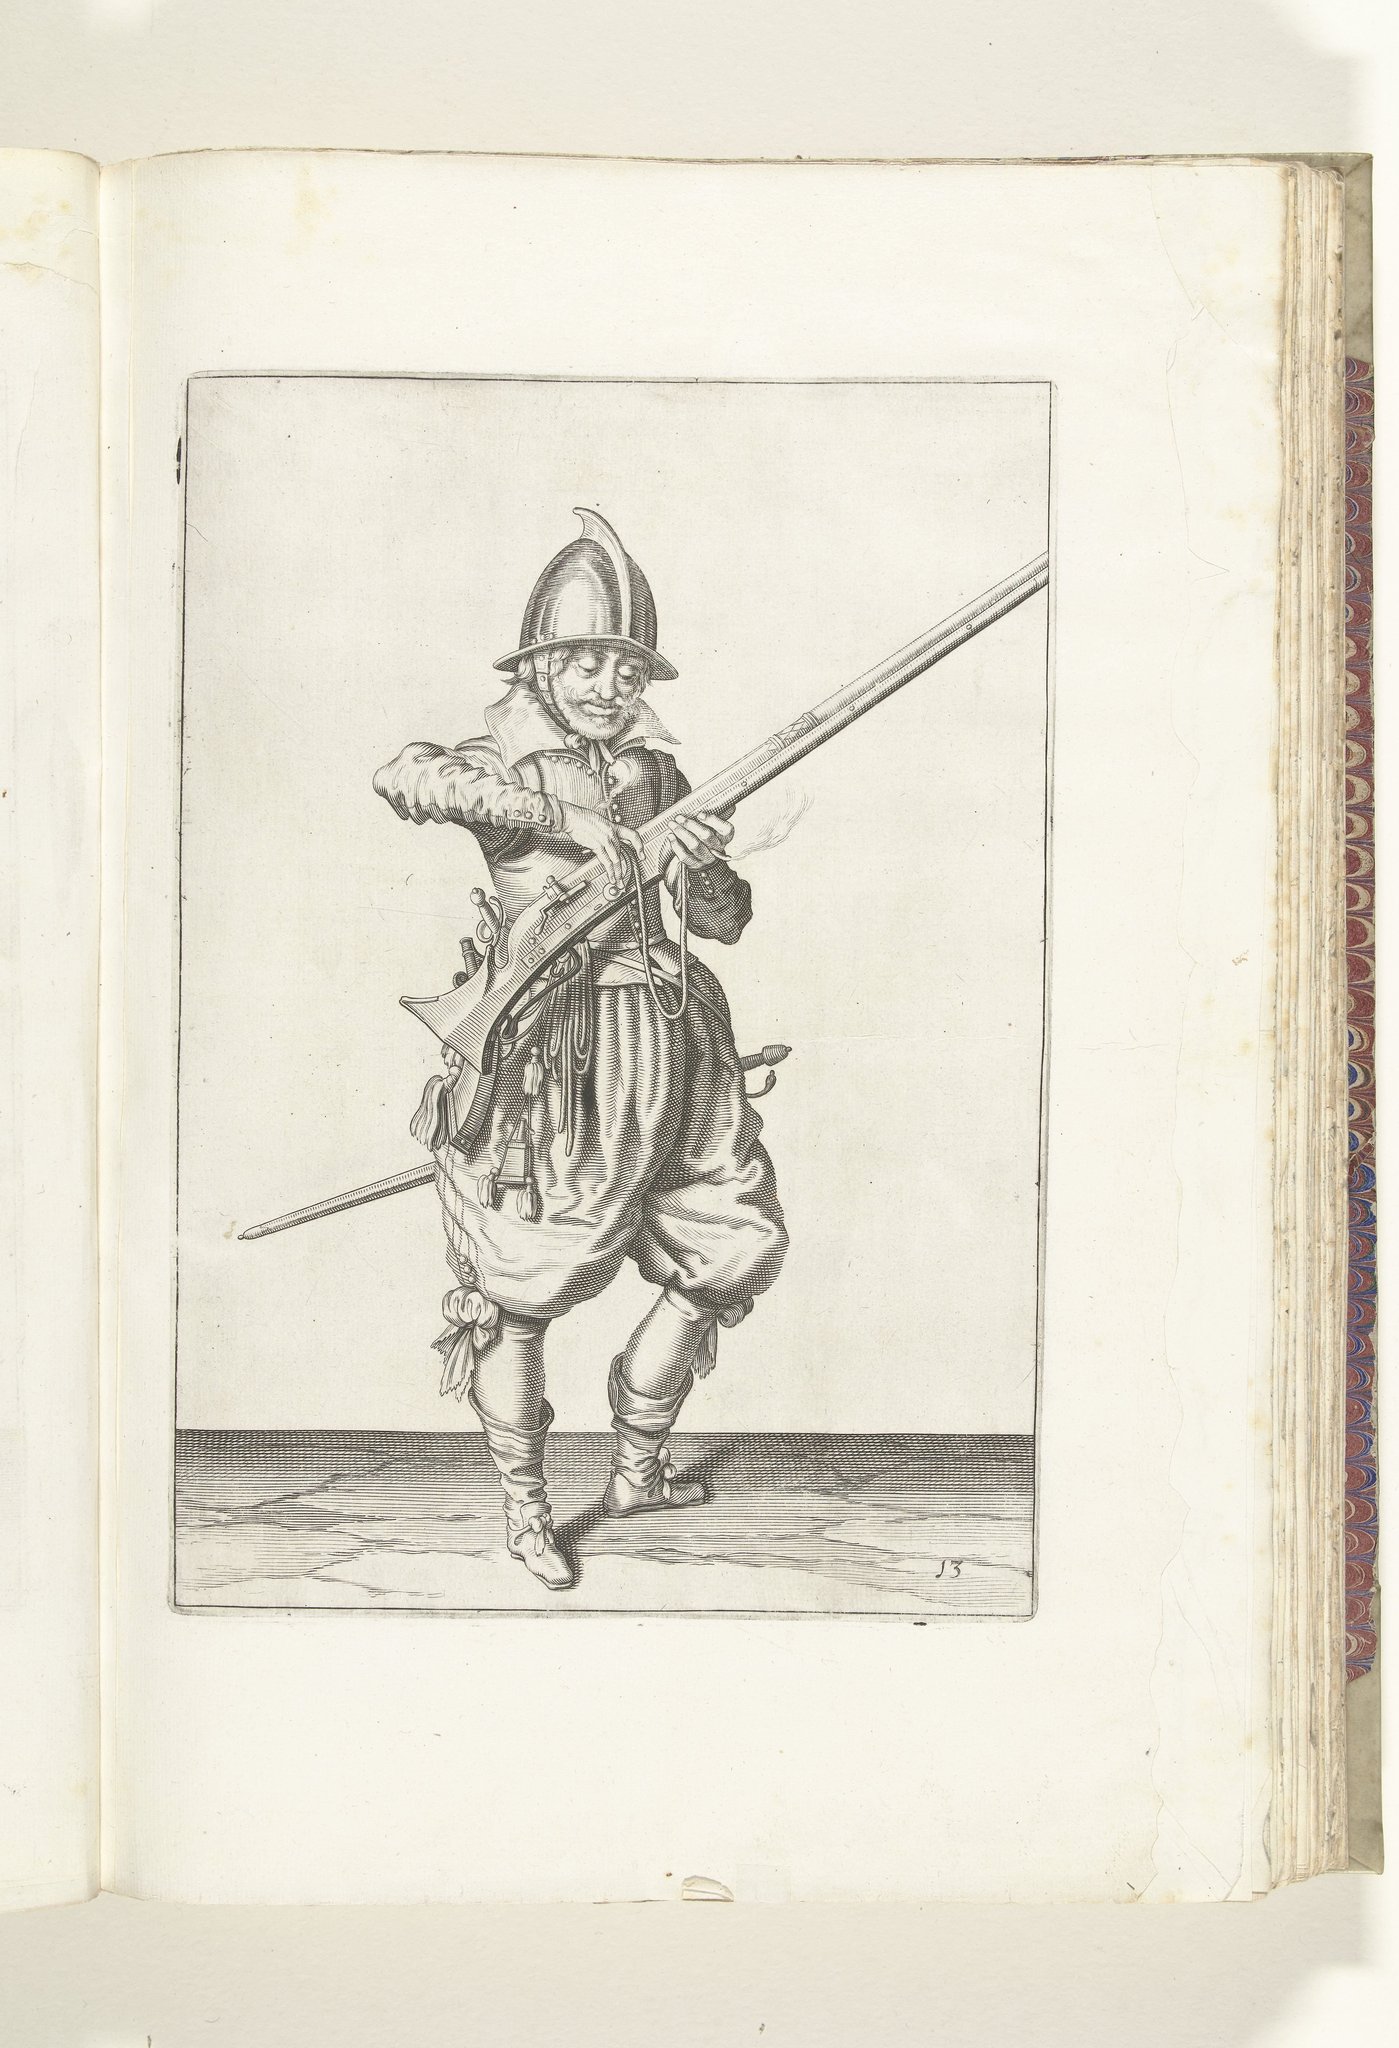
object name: print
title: Soldaat die zijn lont van de haan van zijn roer losmaakt (nr. 13), ca. 1600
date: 1597-1607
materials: paper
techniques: engraving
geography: amsterdam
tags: the hague, maurice (prince of orange), handling of weapons ~ military training, weapons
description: Een soldaat, ten voeten uit, naar rechts, die een roer (een bepaald type vuurwapen) met zijn linkerhand vasthoudt (nr. 13), ca. 1600. Met zijn rechterhand maakt hij de brandende lont los die op de haan (onderdeel van het ontstekingsmechanisme) van zijn roer ligt. Plaat 13 in de instructies voor het hanteren van de roer. Onderdeel van de illustraties in: J. de Gheyn, Wapenhandelinghe van Roers Musquetten ende spiessen, Amsterdam, 1608. Krijgswezen rond 1600.